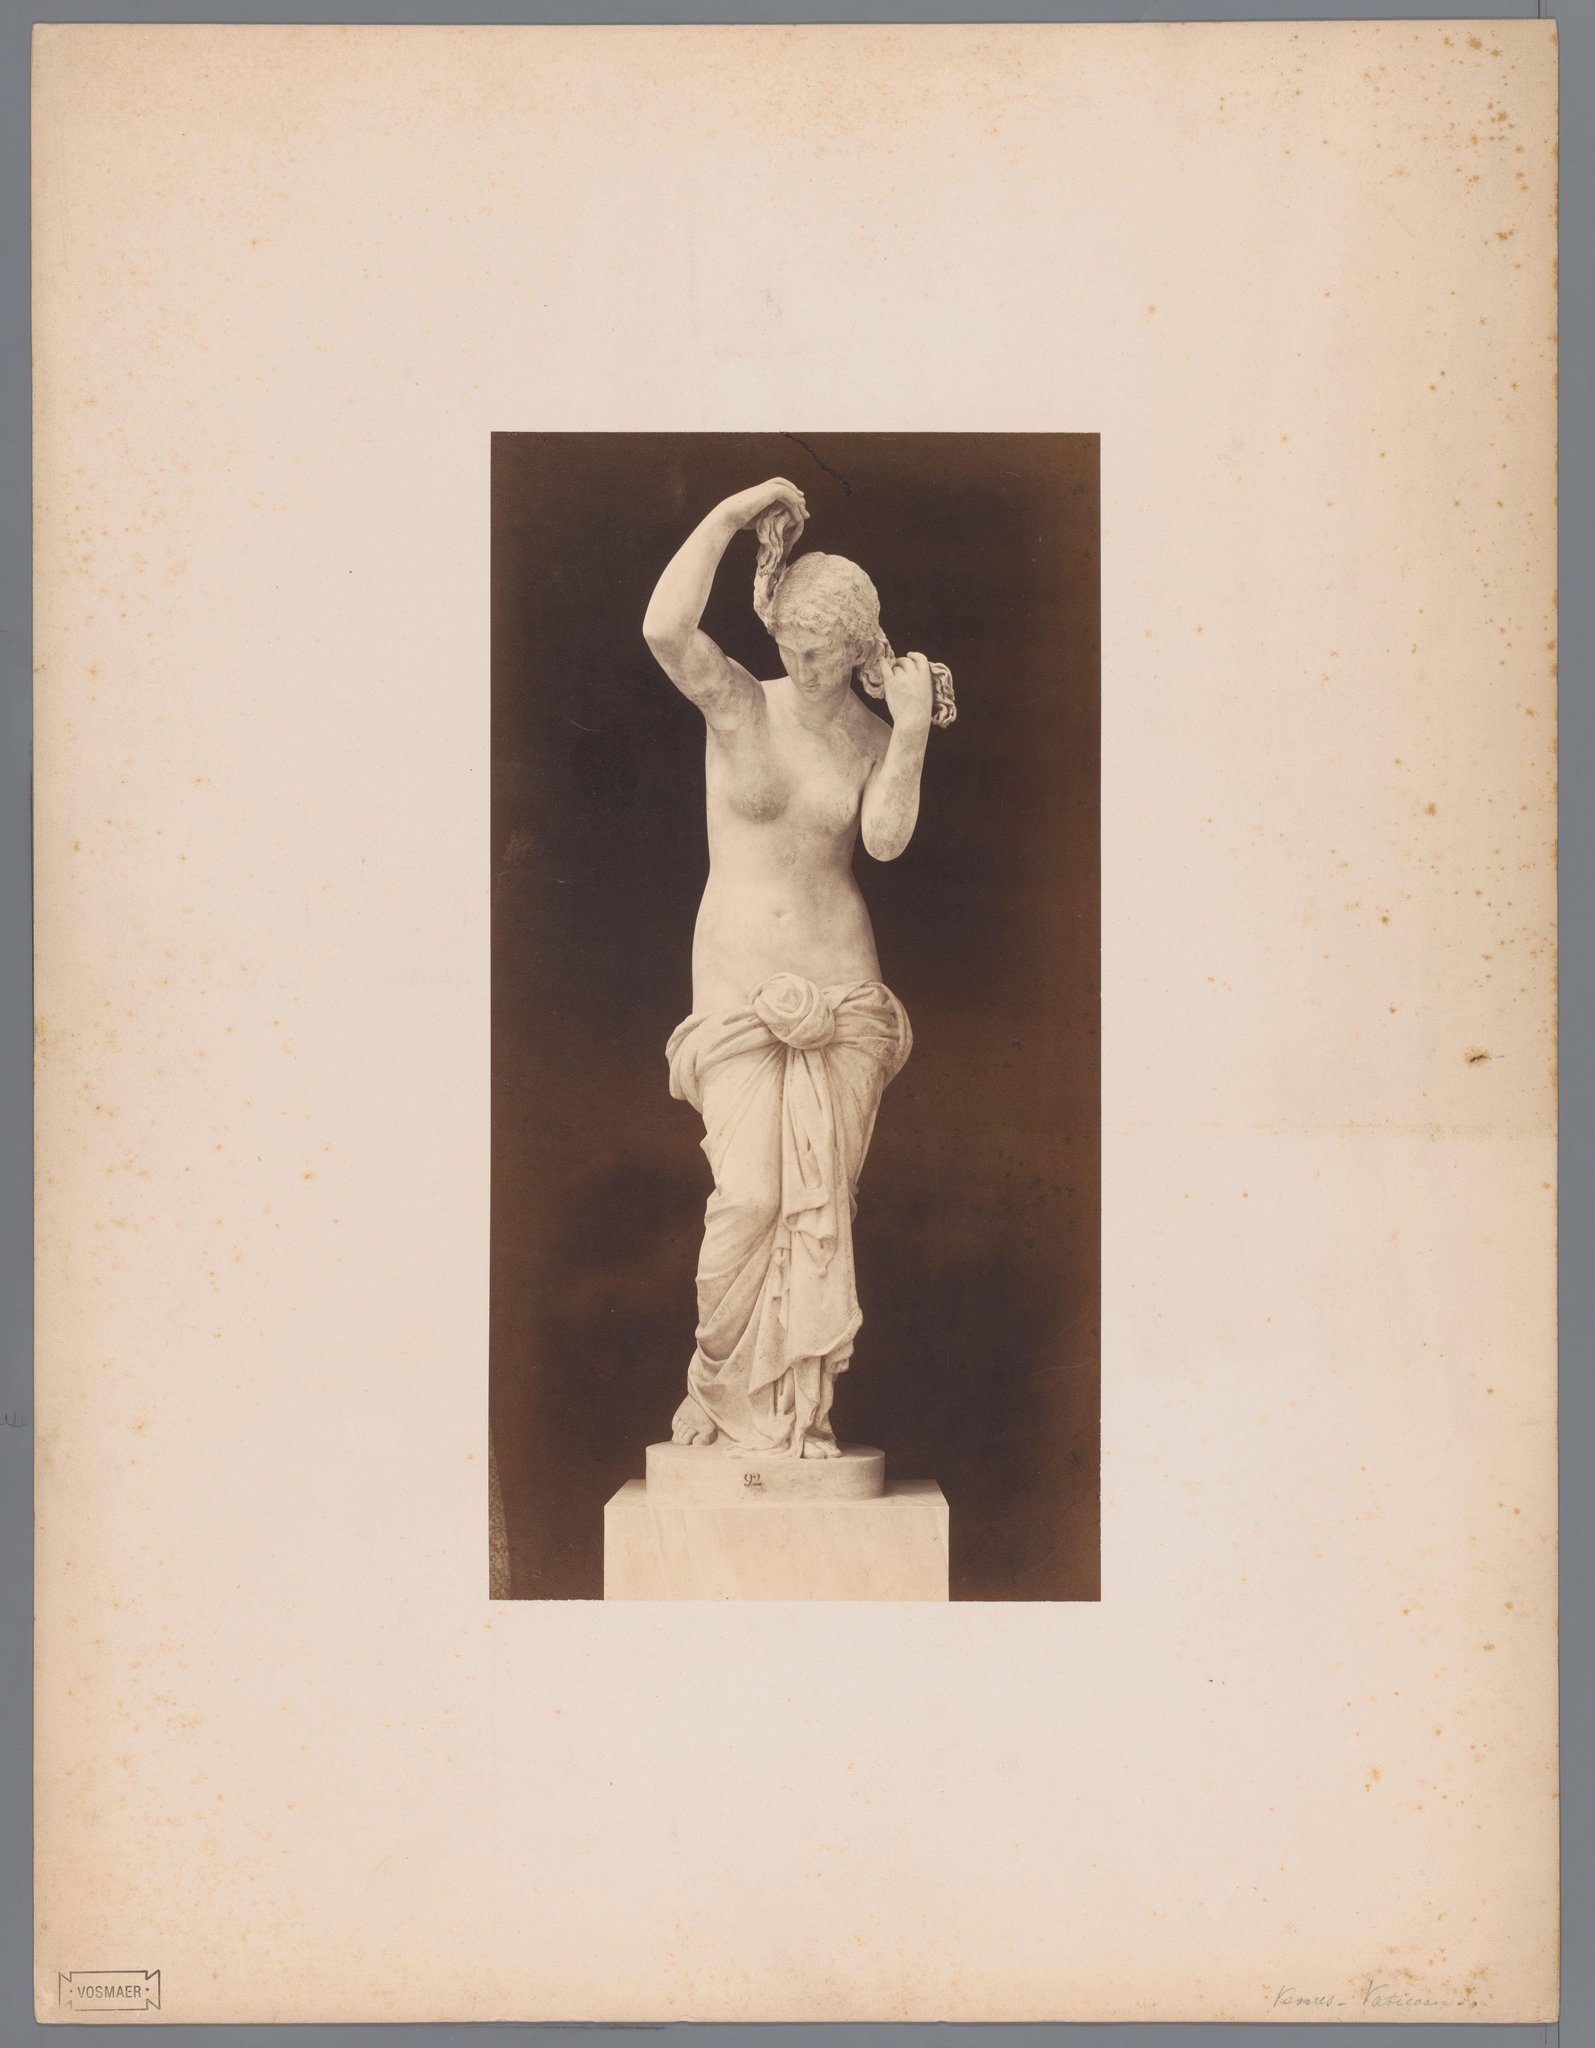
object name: photograph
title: Sculptuur van Venus of Aphrodite, Museo Vaticano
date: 1850-1870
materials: cardboard, paper, photographic support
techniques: albumen print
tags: piece of sculpture, reproduction of a piece of sculpture